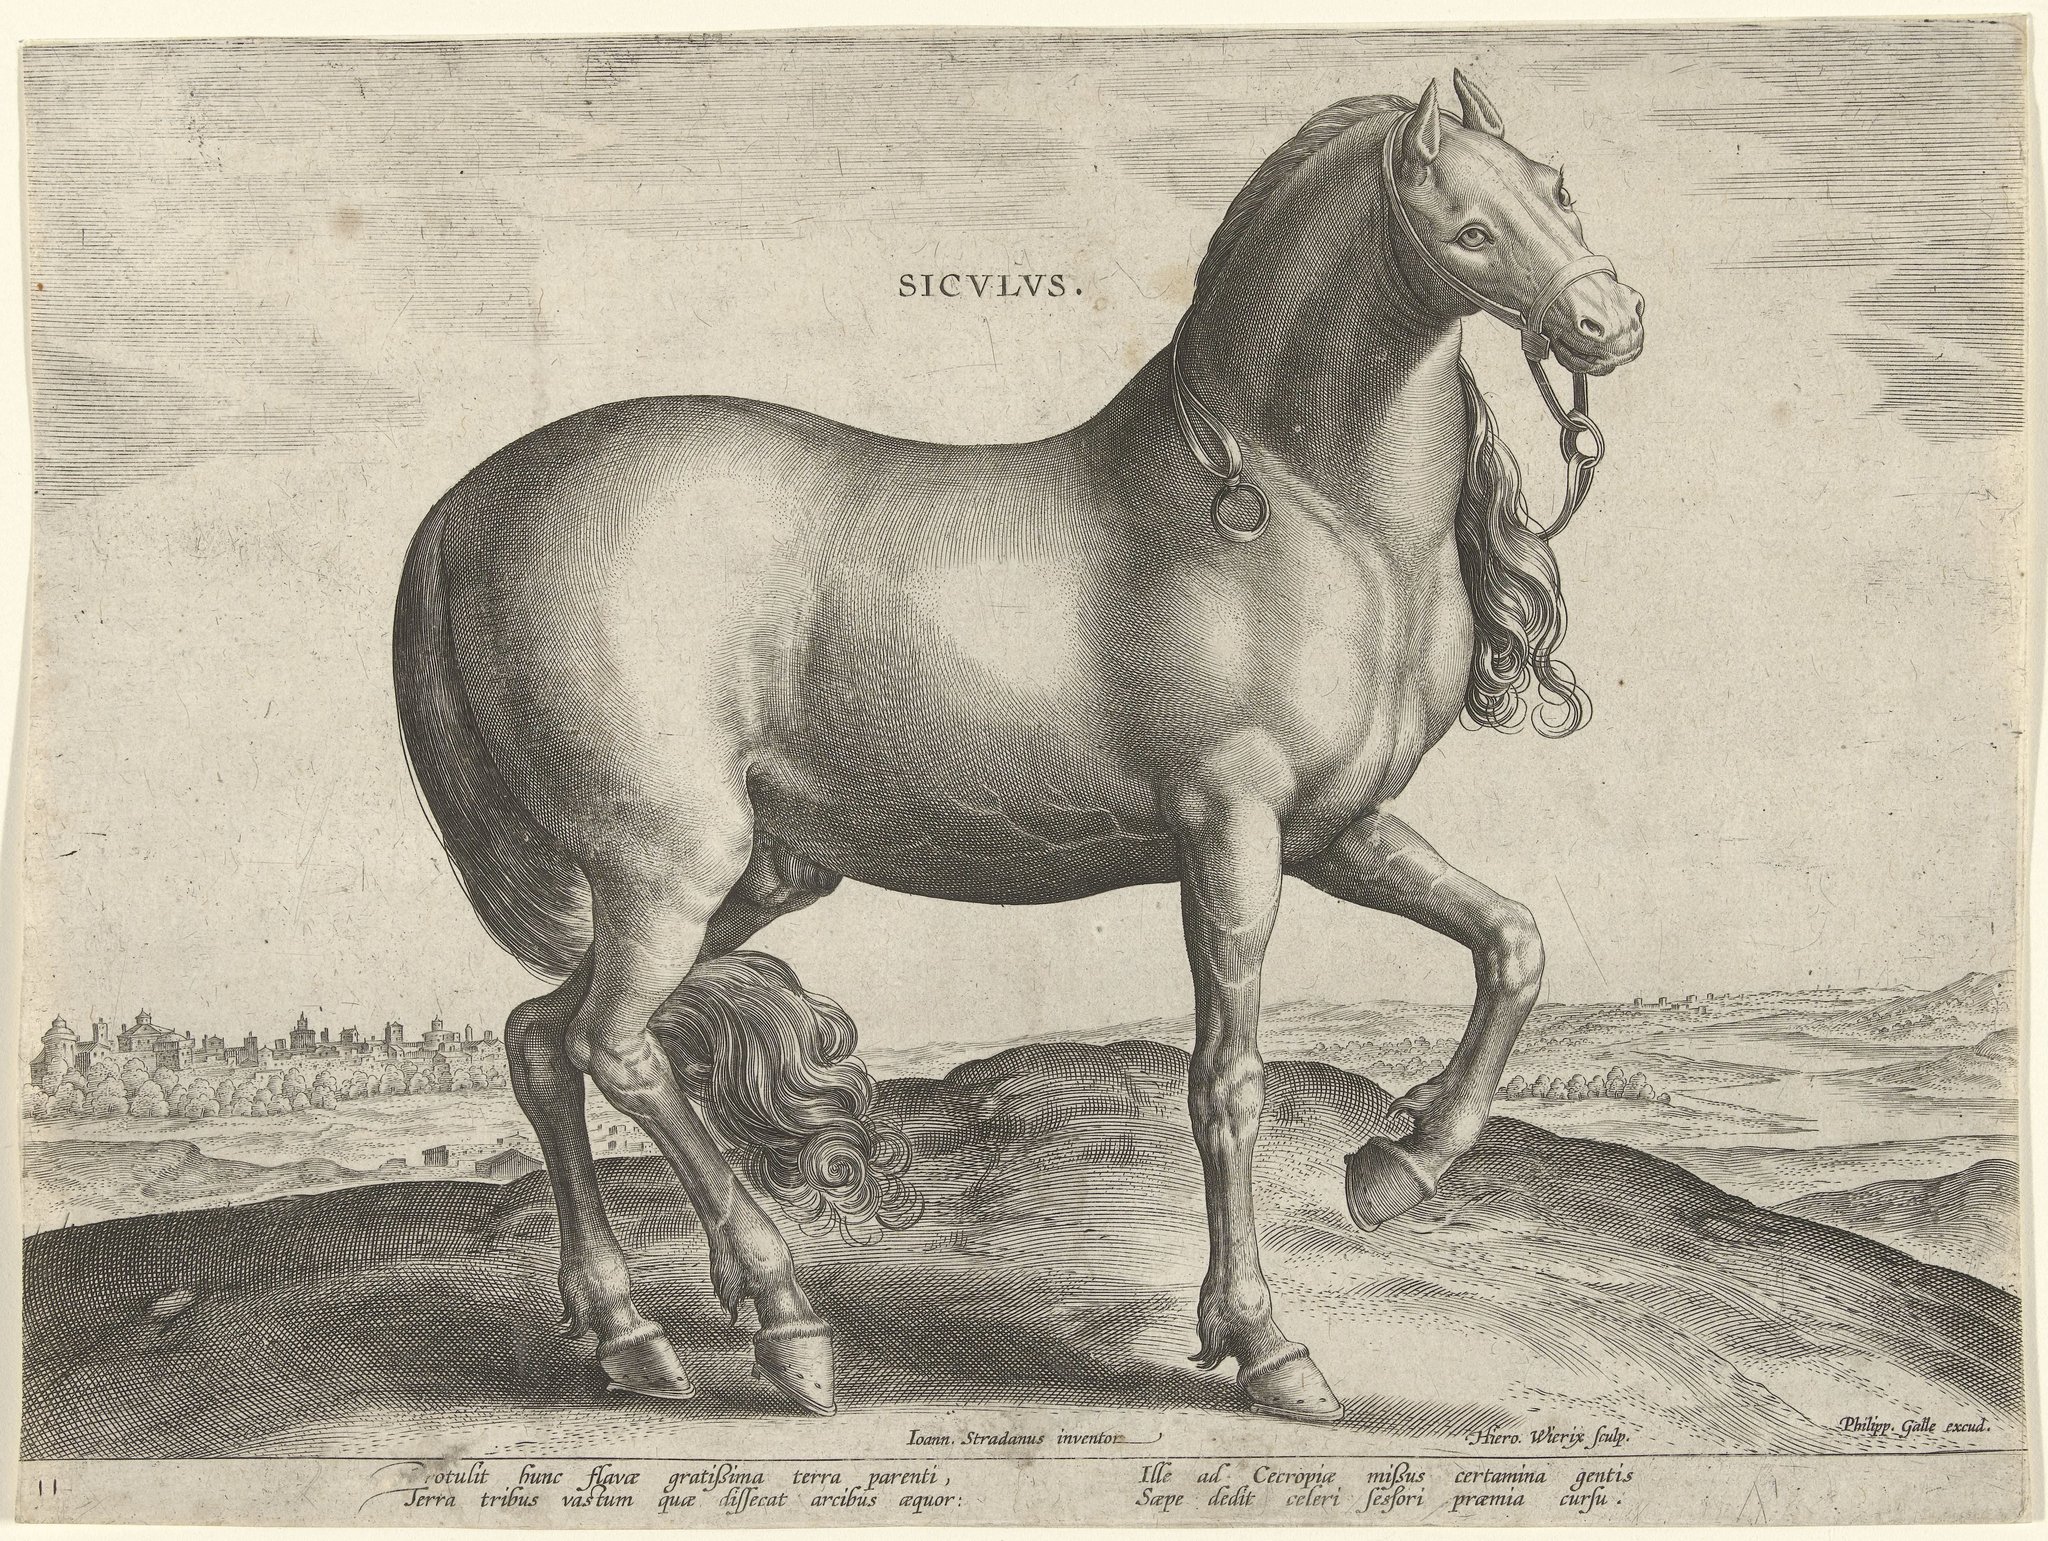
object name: print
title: Equile Ioannis Austriaci Caroli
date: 1583-1587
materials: paper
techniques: engraving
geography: antwerp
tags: don juan van oostenrijk, horses and kindred animals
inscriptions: collector's mark: Lugt 2228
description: Een Siciliaans paard, in profiel. De prent heeft een Latijns onderschrift en maakt deel uit van het eerste deel van een 39-delige serie over de paardenrassen uit Koninklijke stallen van Don Juan van Oostenrijk.